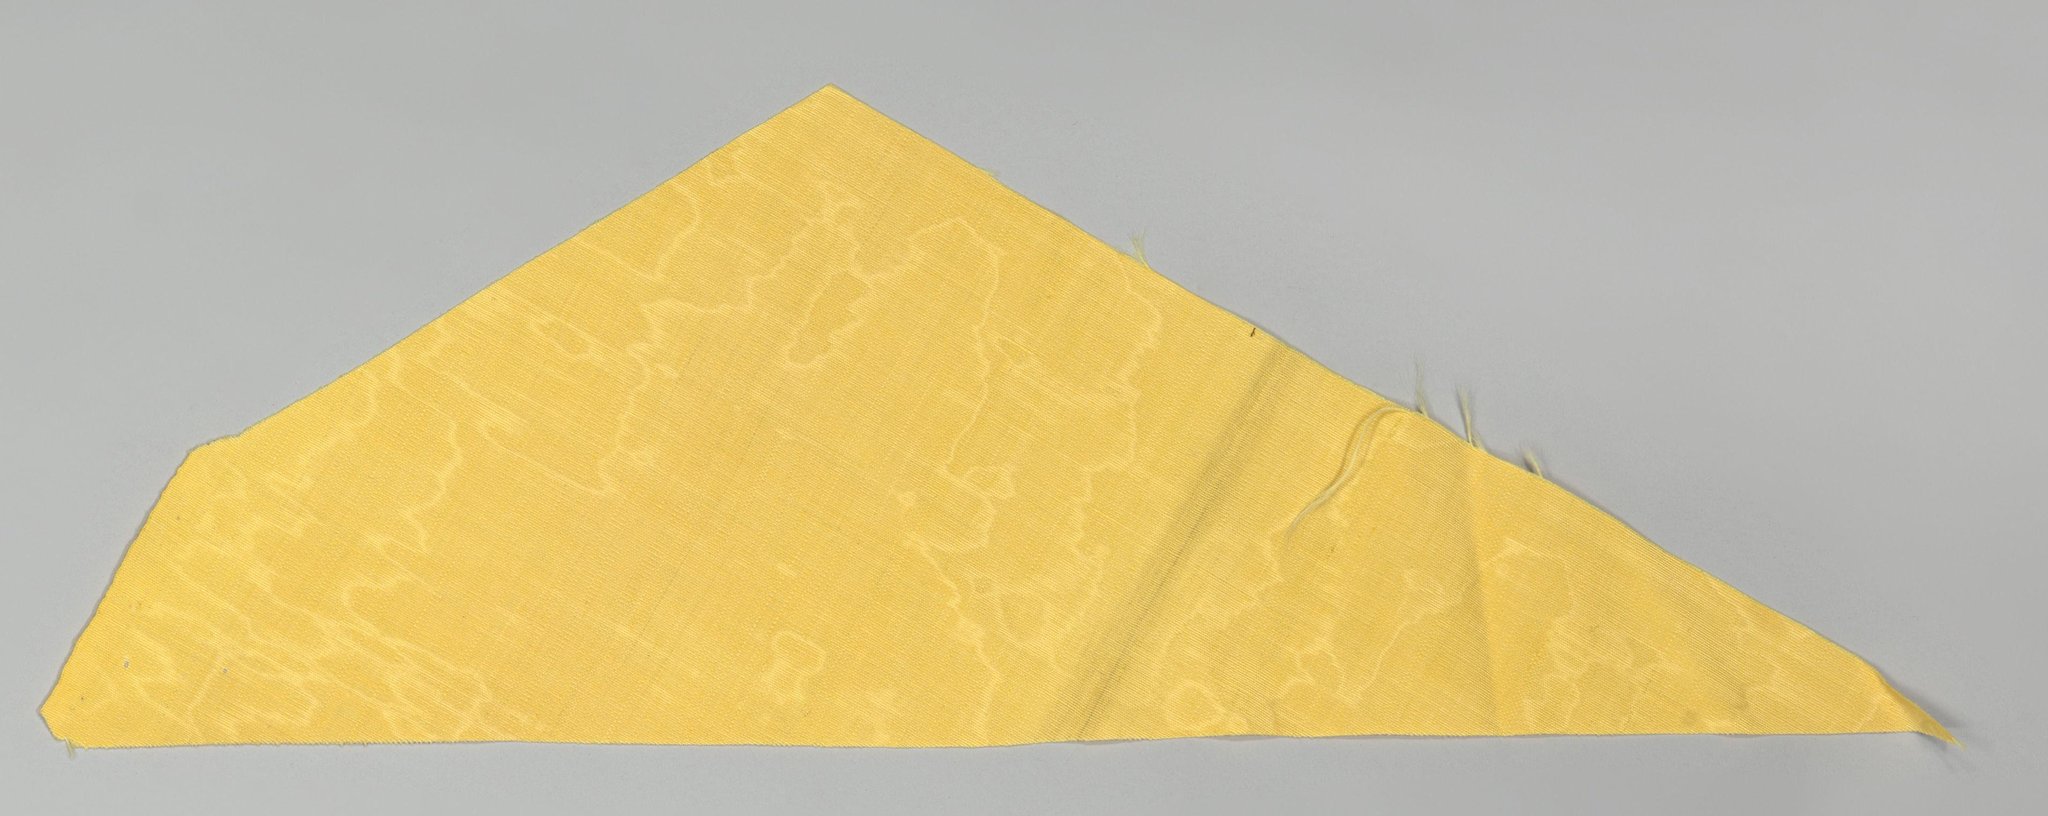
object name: bed covering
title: Fragment van een bedgarnituur van gele gewaterde wol met groen passement en afhangende klosjes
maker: Anonymous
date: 1795-1815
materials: wool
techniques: moire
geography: northern netherlands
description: Fragment van een bedgarnituur van gele gewaterde wol, omboord met groen passement met een geel motief en met een groen en geel boordsel met afhangende klosjes die met gele en groene zijde zijn omwonden.